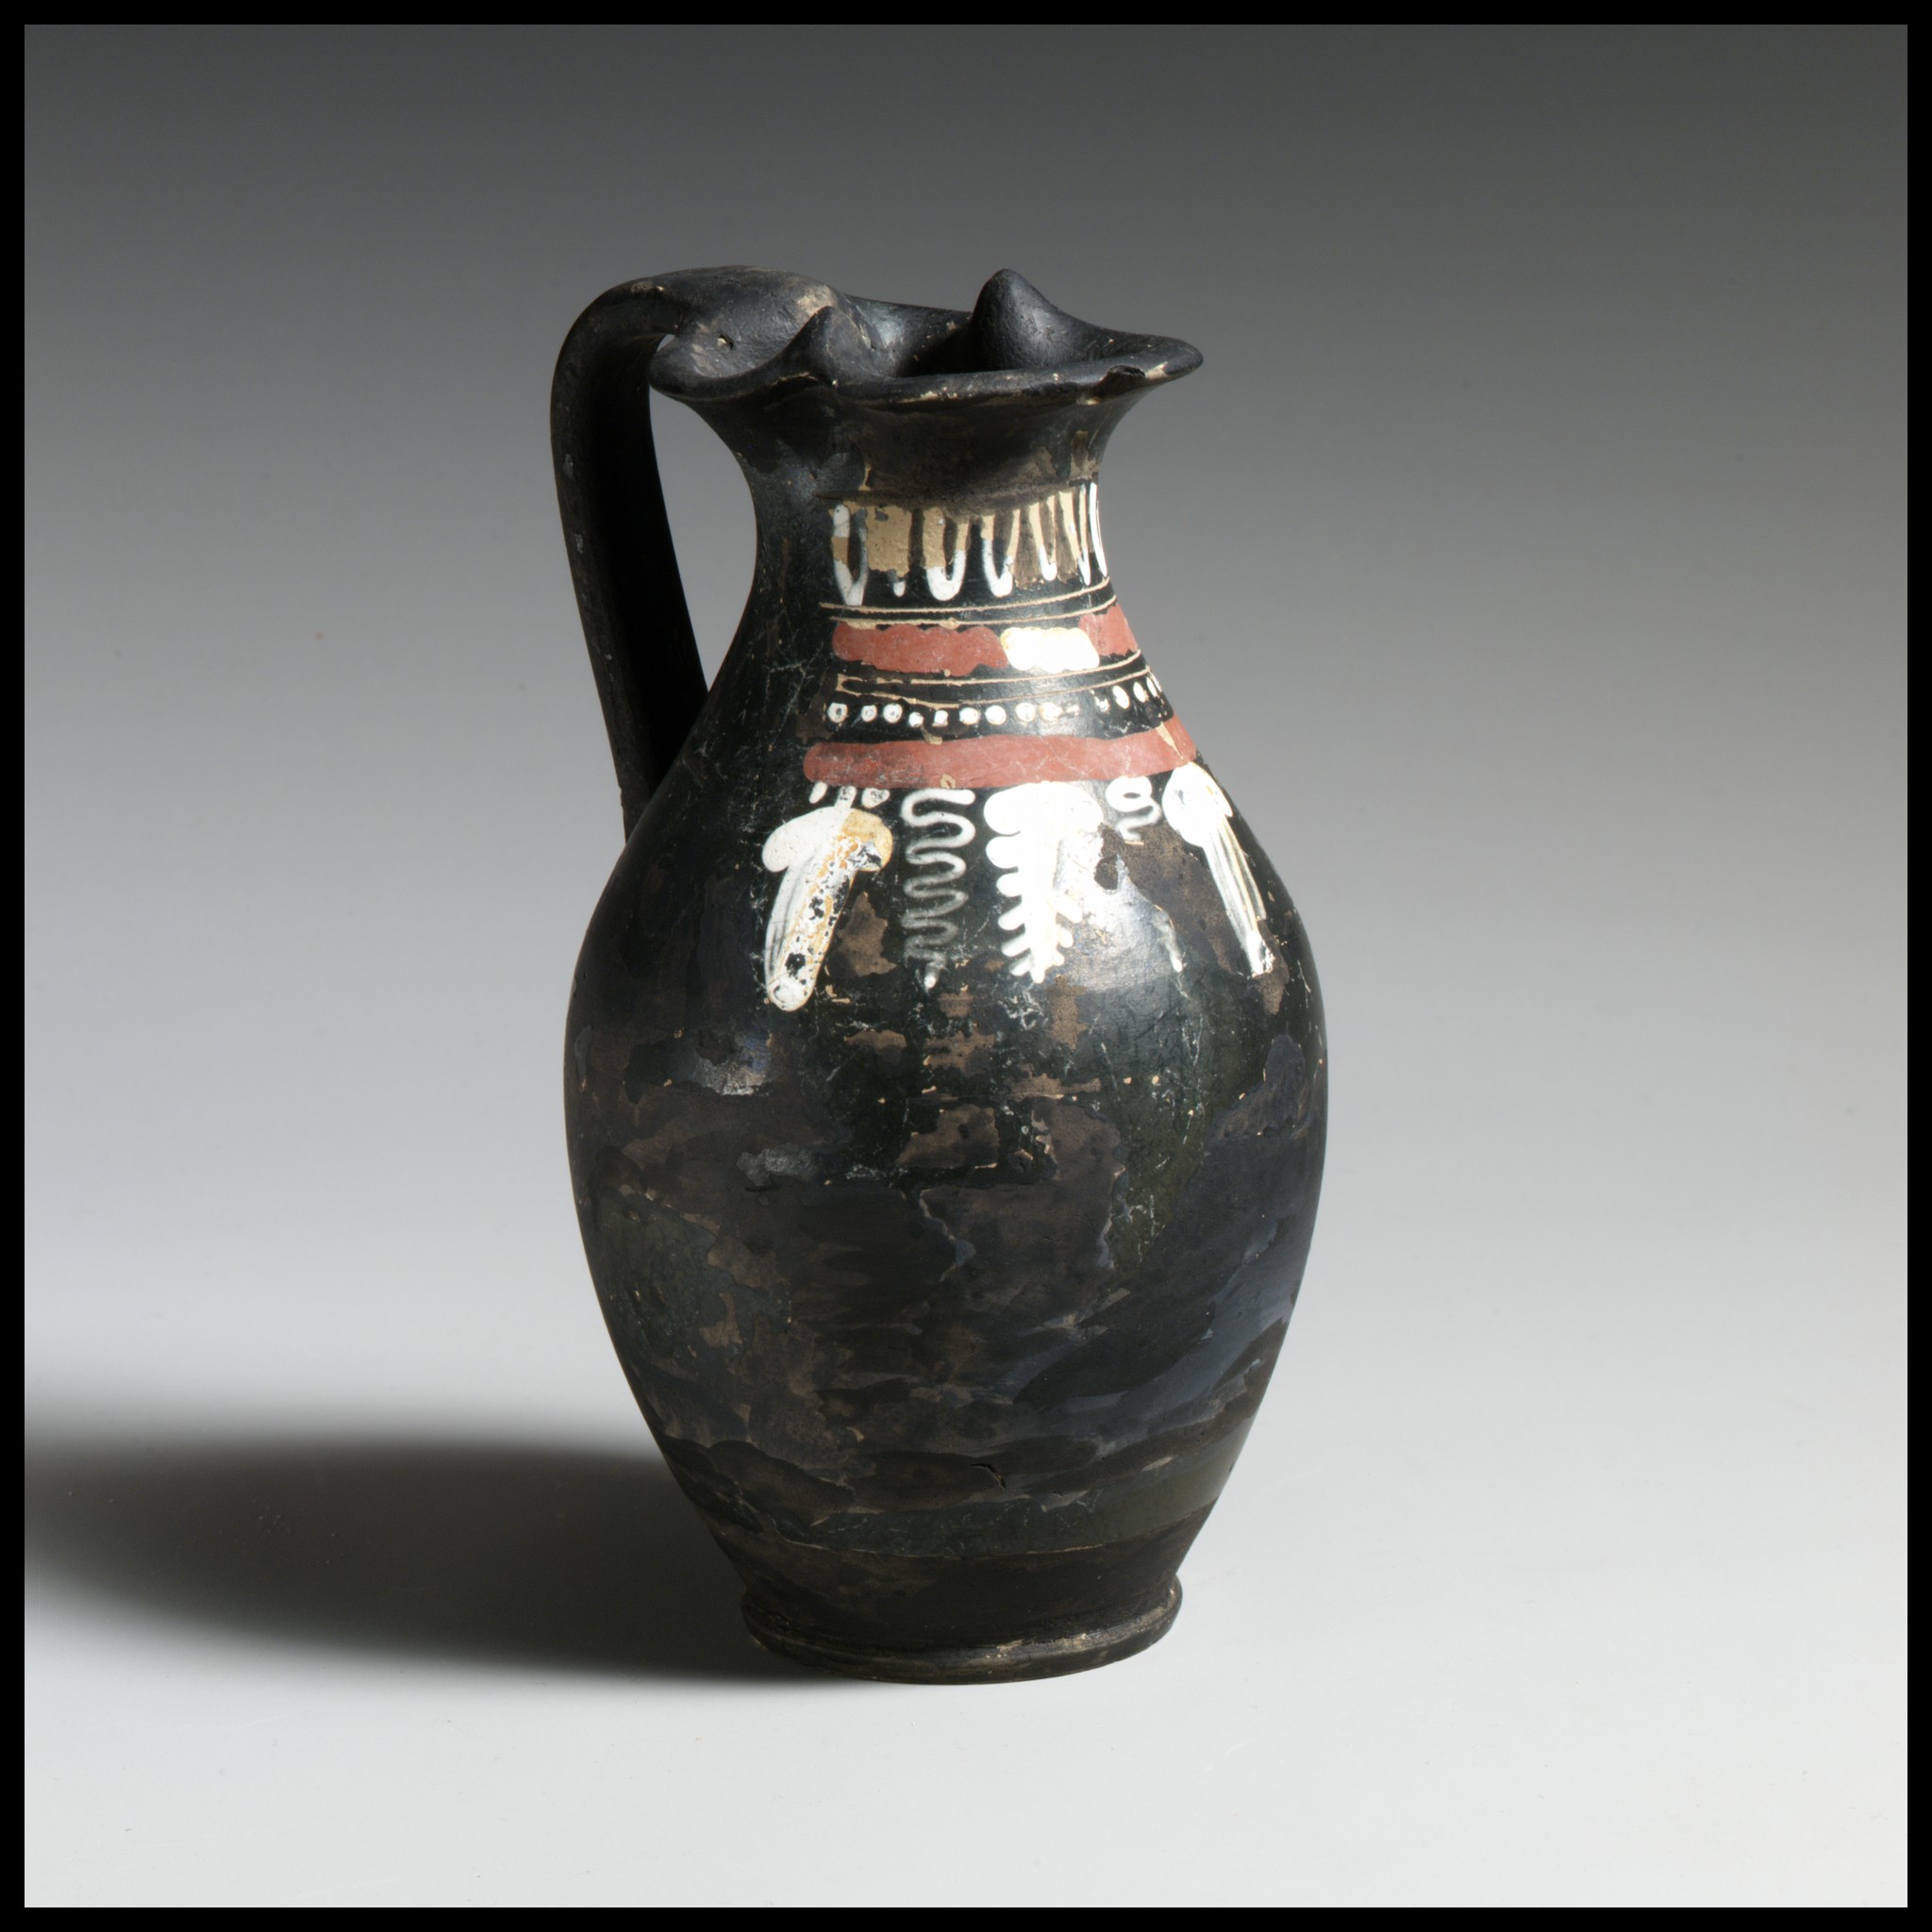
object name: oinochoe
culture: greek, south italian, apulian, canosan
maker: knudsen group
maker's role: artist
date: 350-300 BCE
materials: terracotta